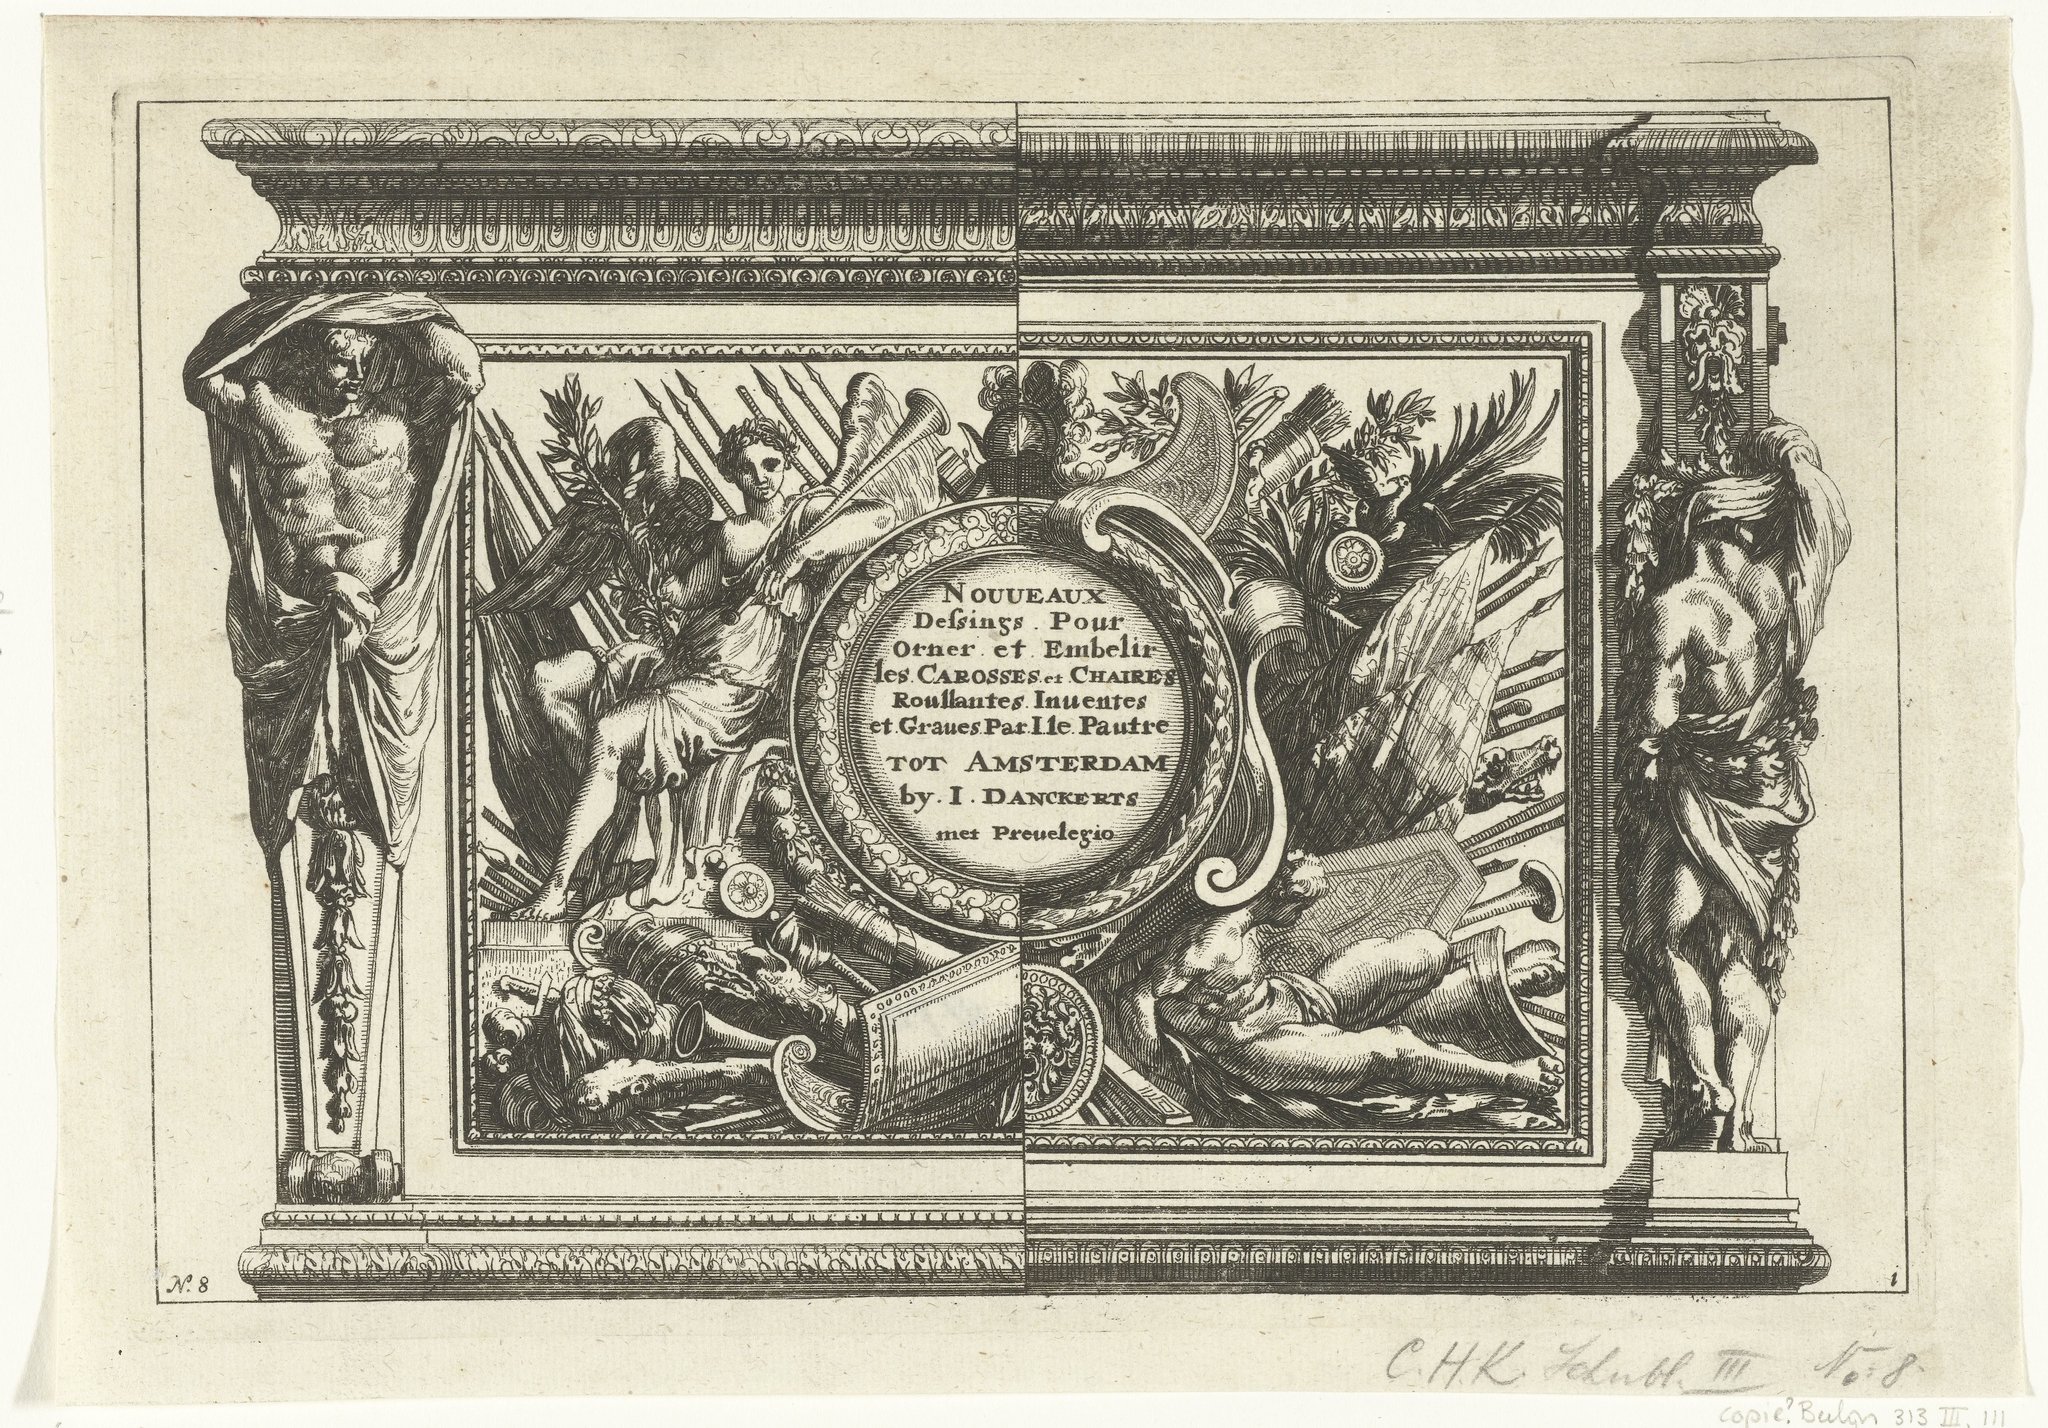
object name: ornament print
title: New Designs for Ornamenting and Embellishing Coaches and Carriages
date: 1680-1701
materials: paper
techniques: etching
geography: amsterdam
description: Onderkant van het lichaam van een koets of een draagstoel, met variant voor de rechterhelft. De tekst staat op een medaillon in het midden.